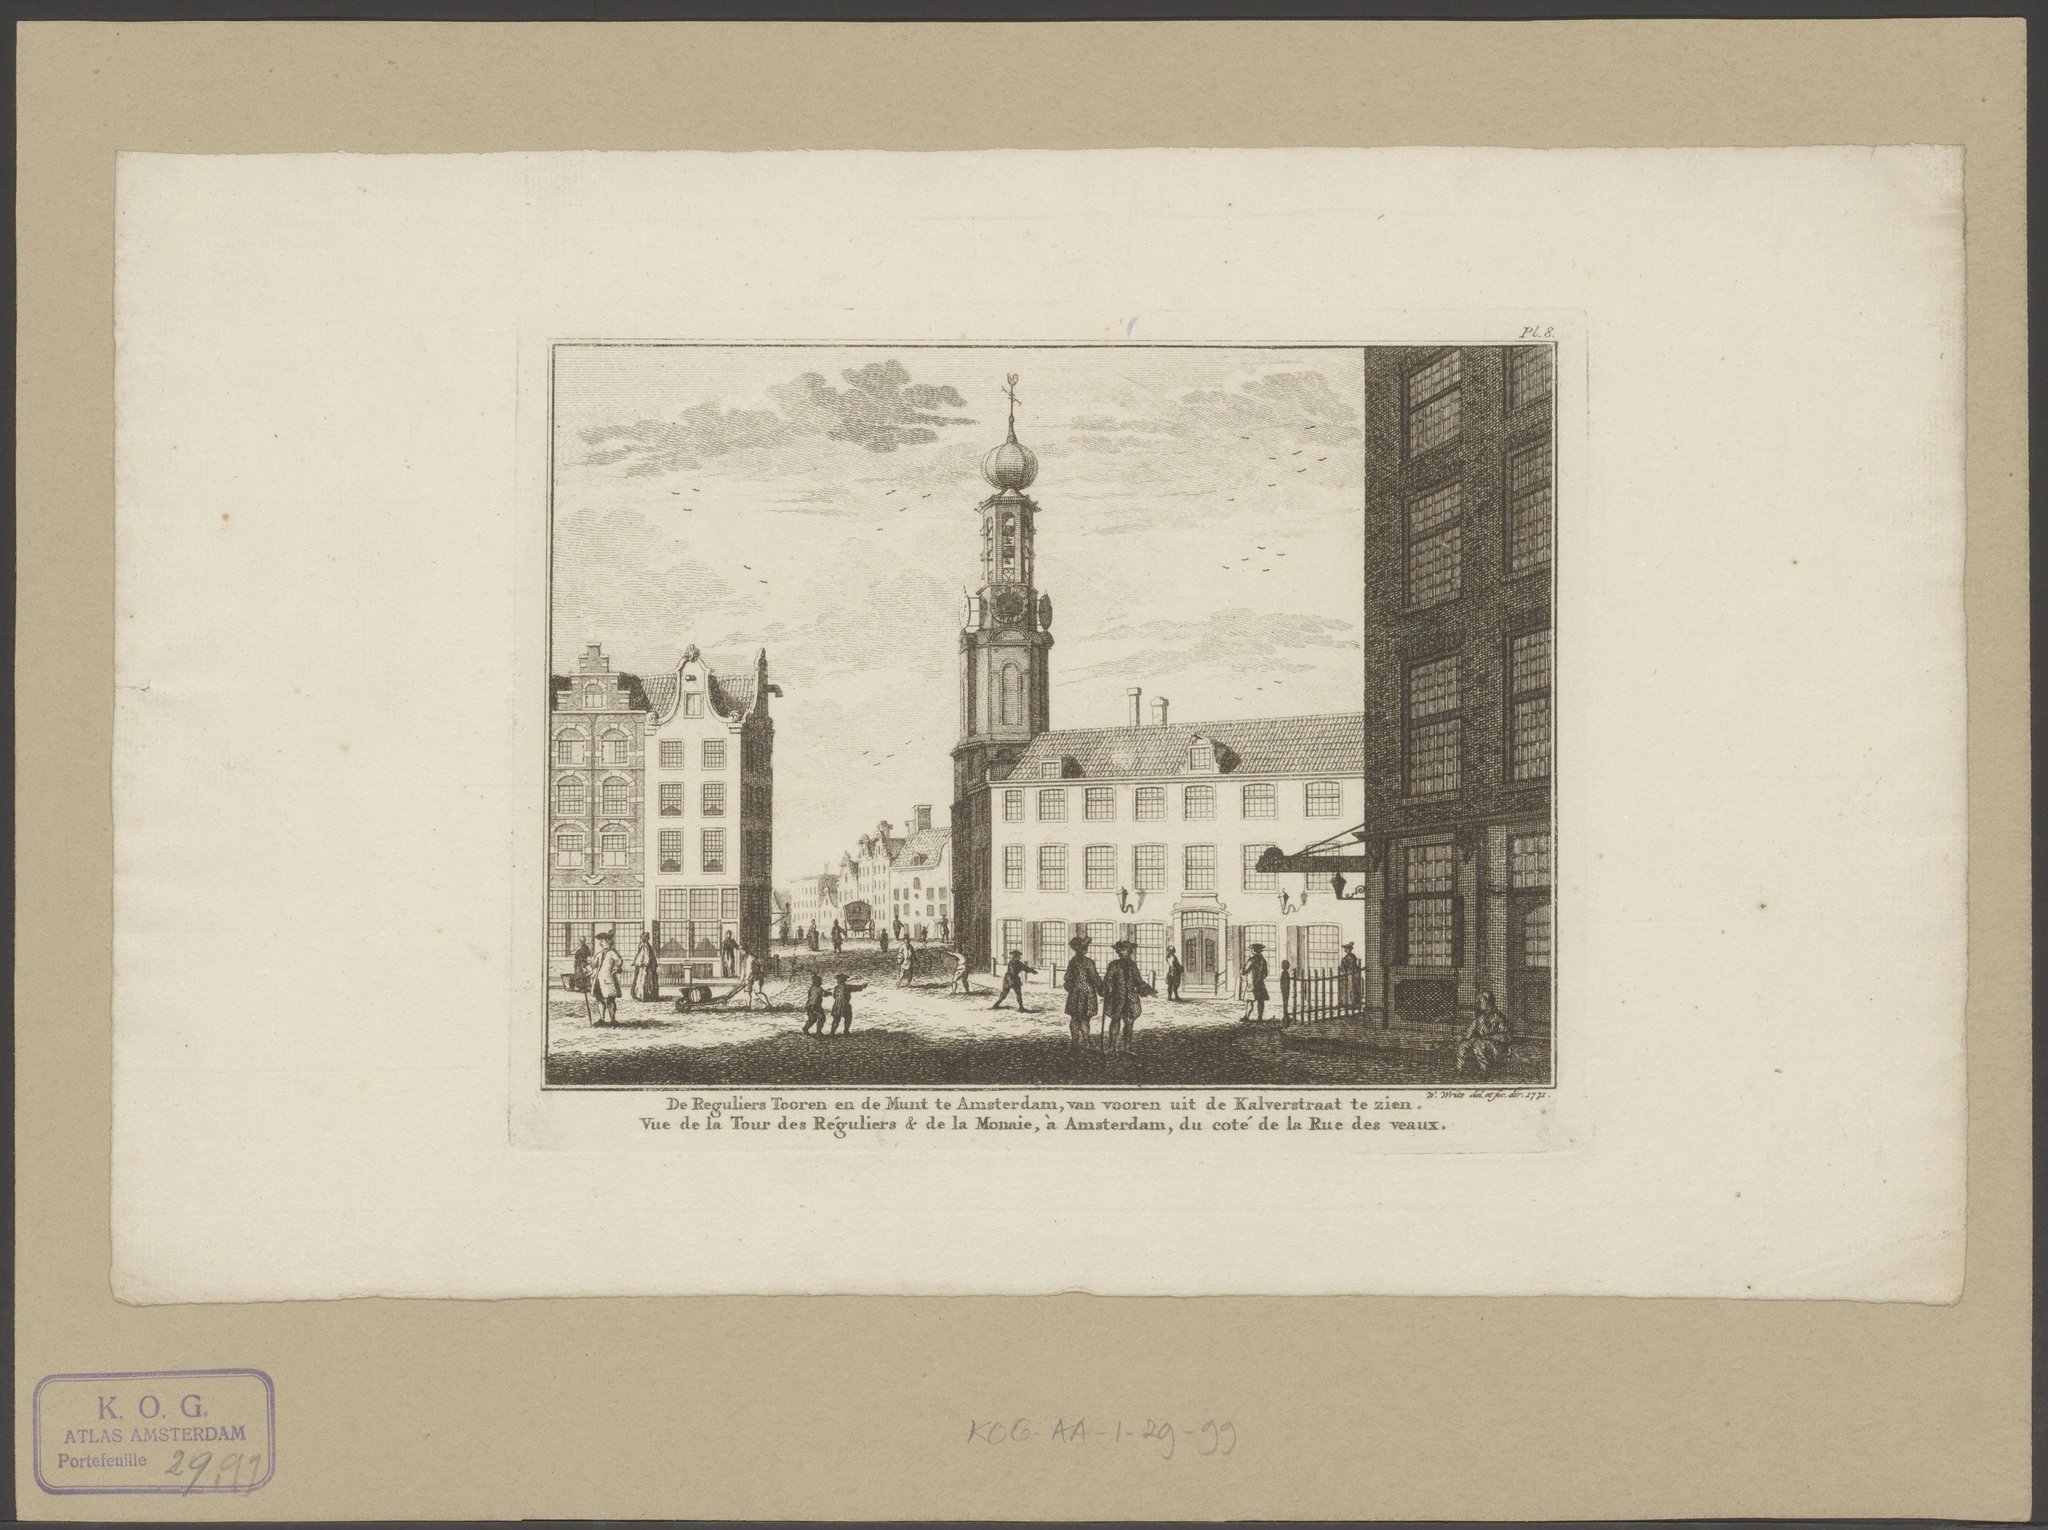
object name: print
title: Gezicht op de Munttoren te Amsterdam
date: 1824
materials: paper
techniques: engraving, etching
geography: amsterdam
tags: tower, clock tower ~ monumental adornment, street (+ city(-scape) with figures, staffage)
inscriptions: collector's mark: Lugt 1641b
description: Prent mogelijk uit: Atlas, of Verzameling van afbeeldingen der voornaamste gebouwen, torens en gezichten der stad Amsterdam (...). Amsterdam: Hendrik Moolenyzer, [1824].